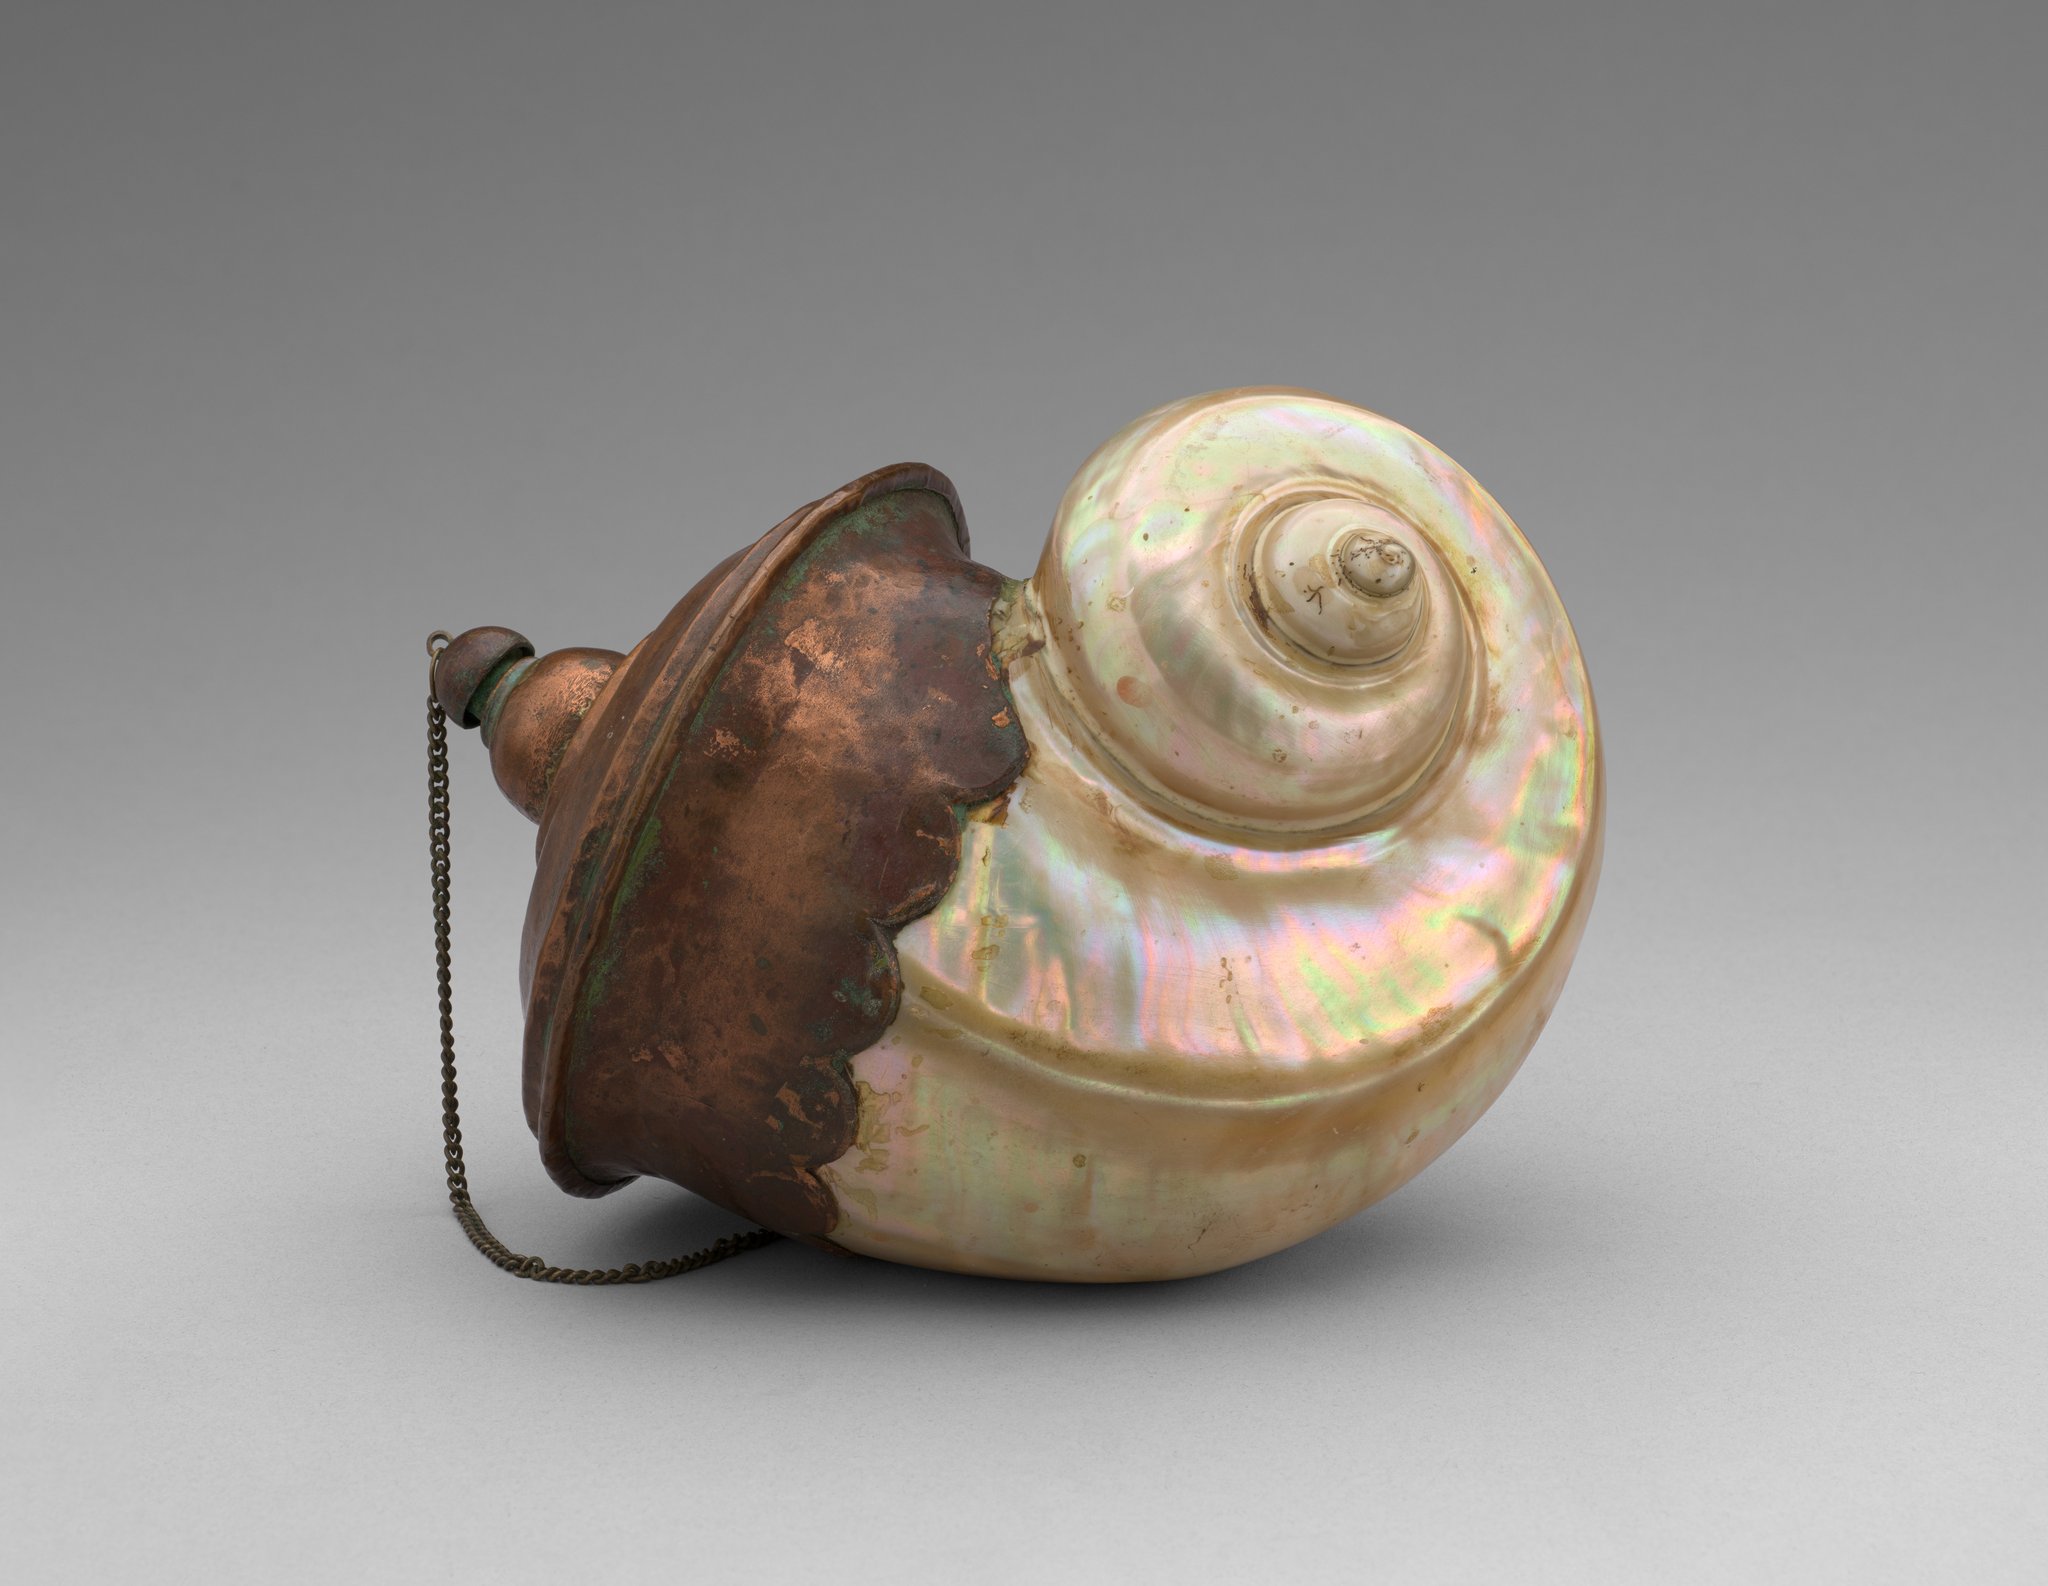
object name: covered container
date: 1701-1900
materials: copper, shell